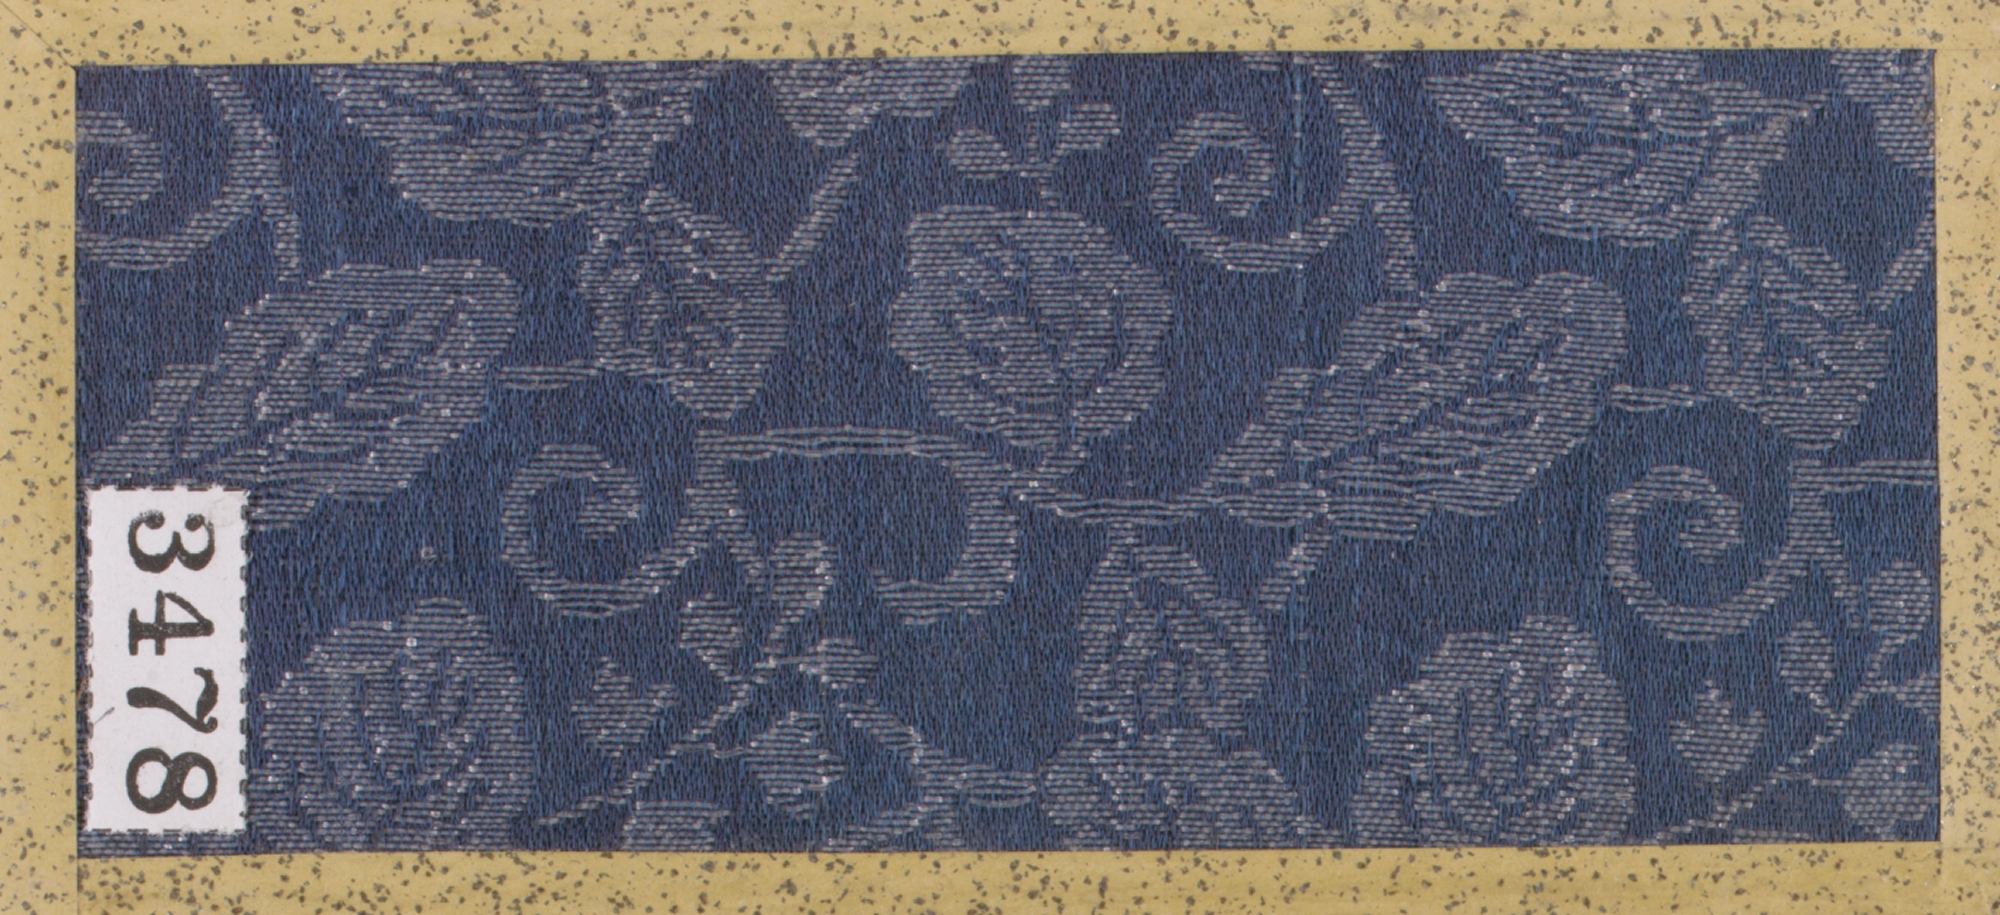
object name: sample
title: Textile Sample from Sample Book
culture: japanese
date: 1801-1900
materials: silk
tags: leaves